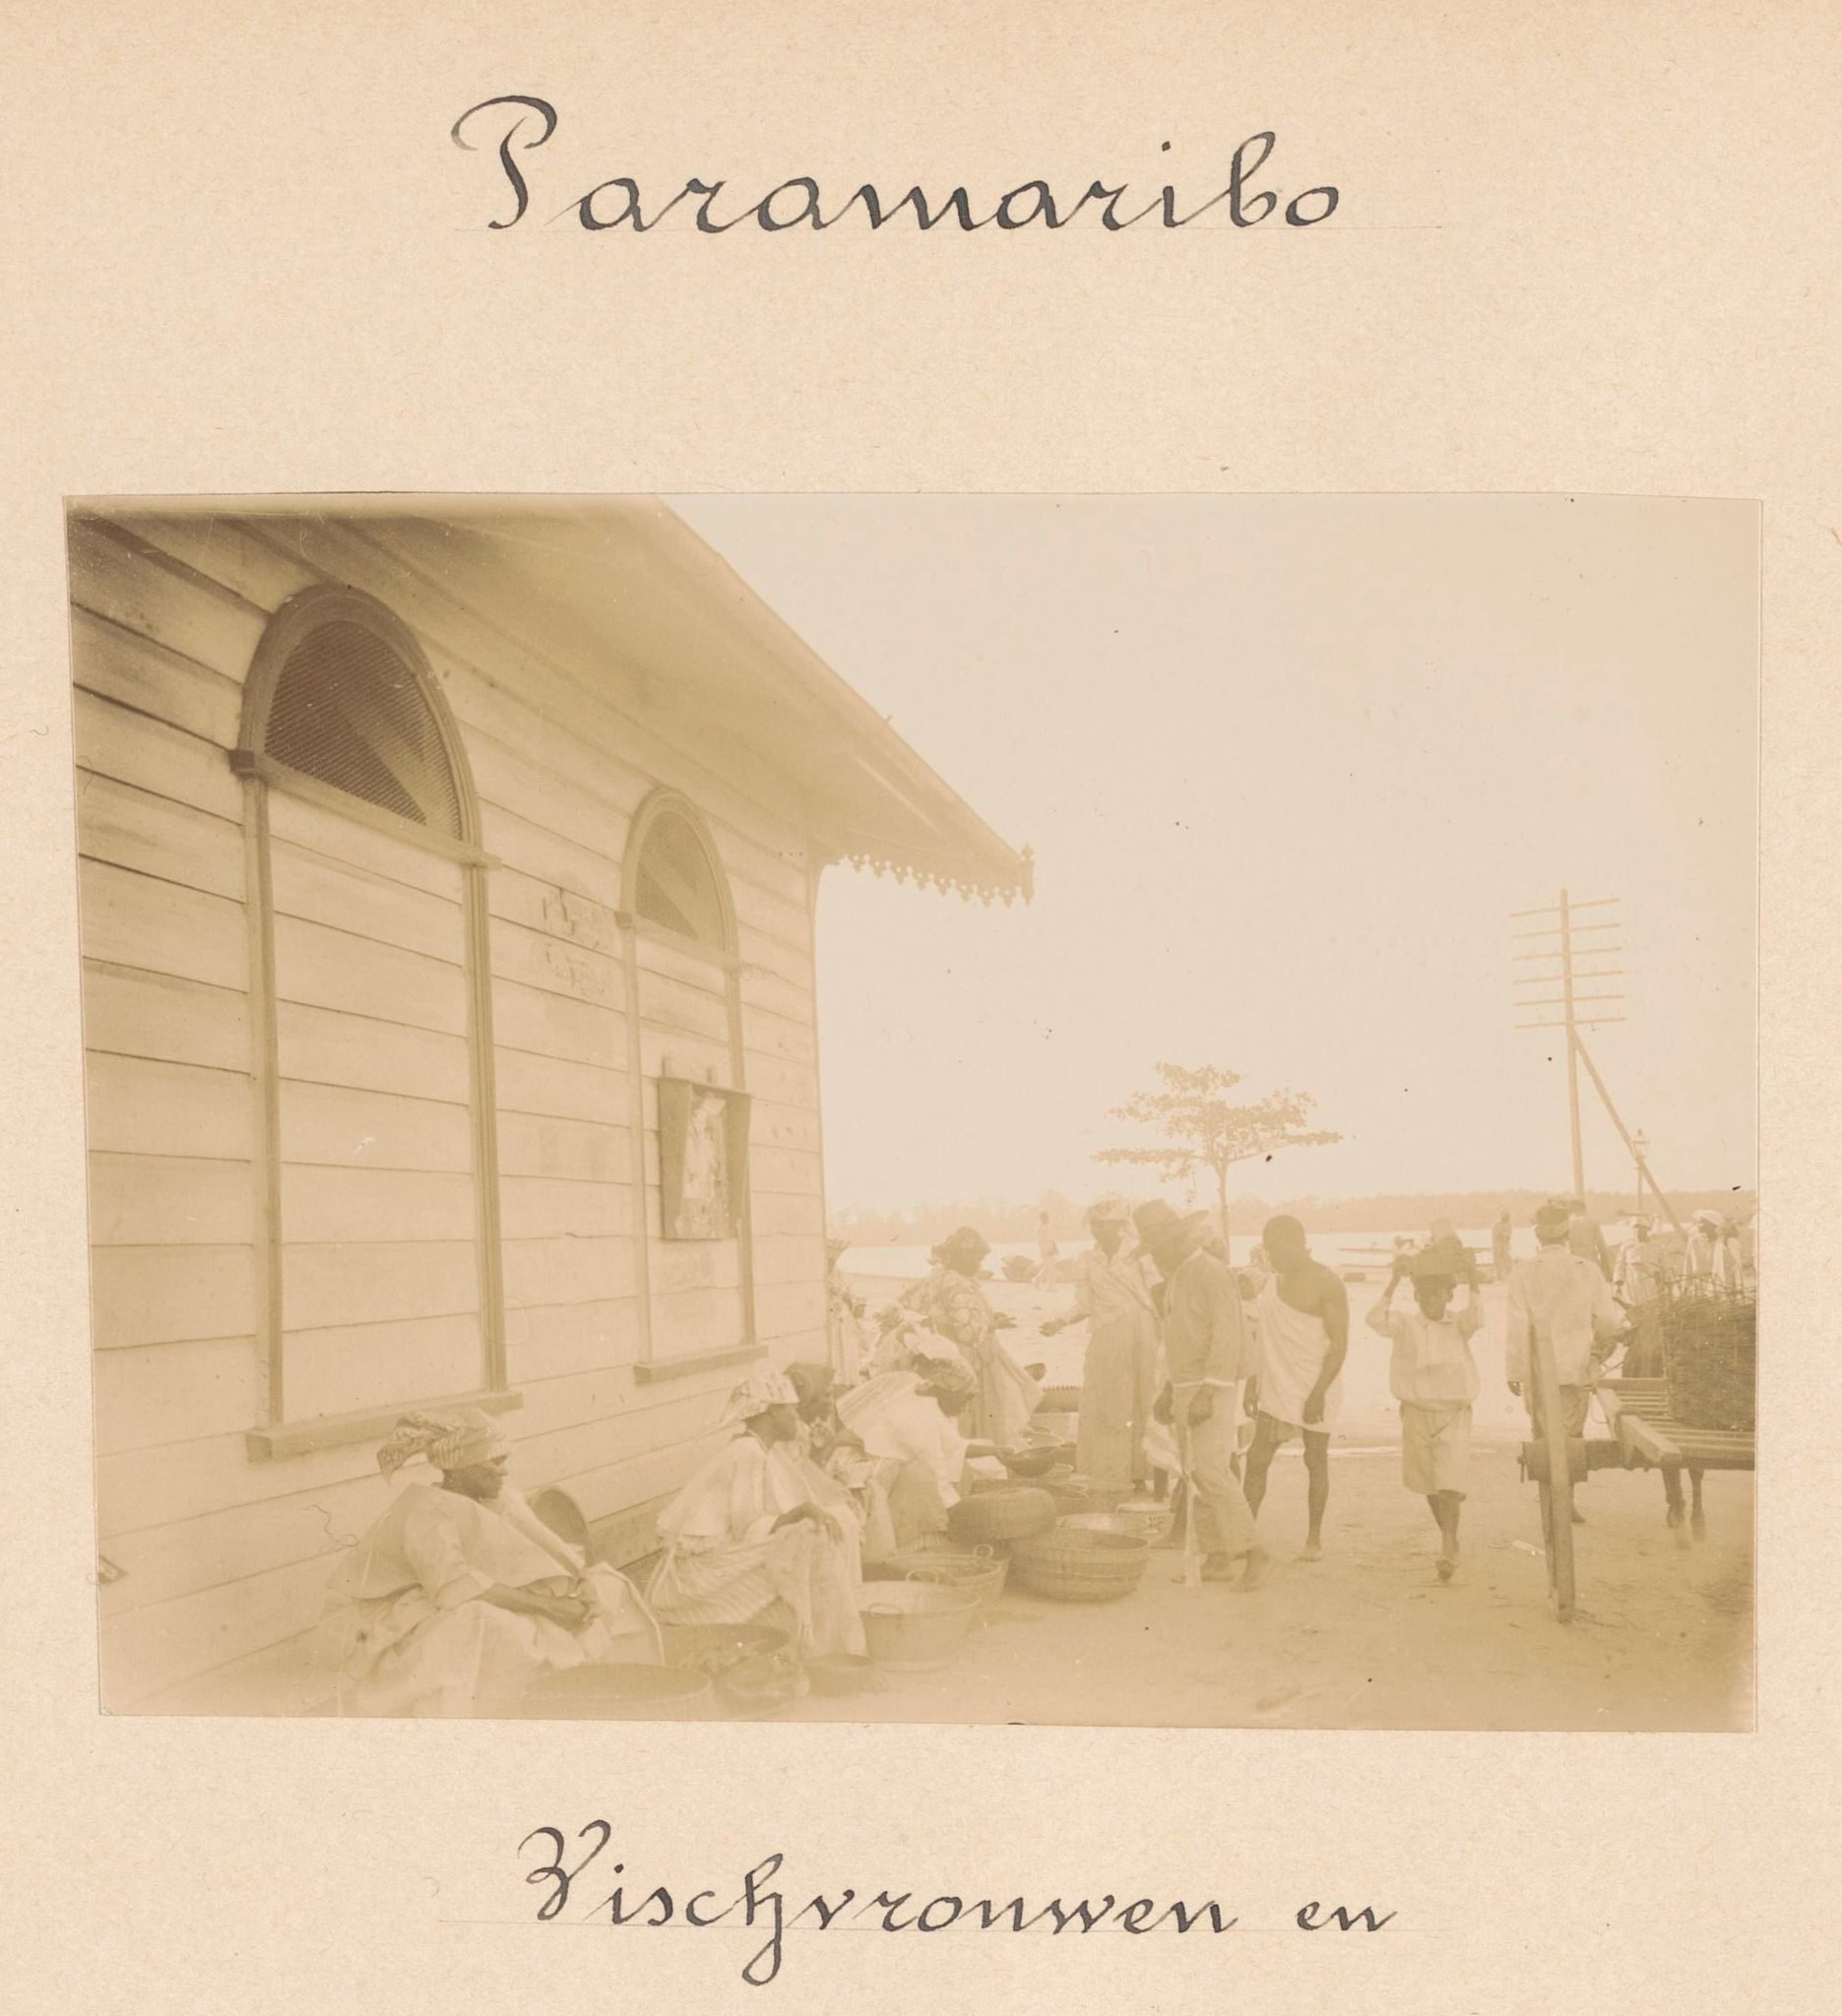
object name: photograph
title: Vischvrouwen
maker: eugen klein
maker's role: fotograaf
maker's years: 1869-1927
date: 1900-1905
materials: cardboard, photographic support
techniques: gelatin silver print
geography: paramaribo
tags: paramaribo (stad)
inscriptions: inscription: ‘Paramaribo / Vischvrouwen en’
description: Surinaamse vrouwen verkopen vis op straat, te Paramaribo. Onderdeel van een groep van 44 foto's van Paramaribo, Suriname en Curaçao, ca. 1900-1905, opgeplakt op kartons en voorzien van opschriften.